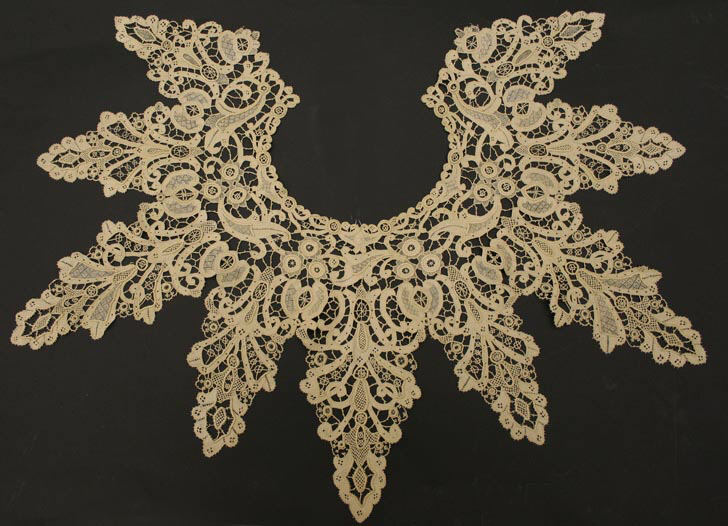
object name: collar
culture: irish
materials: linen